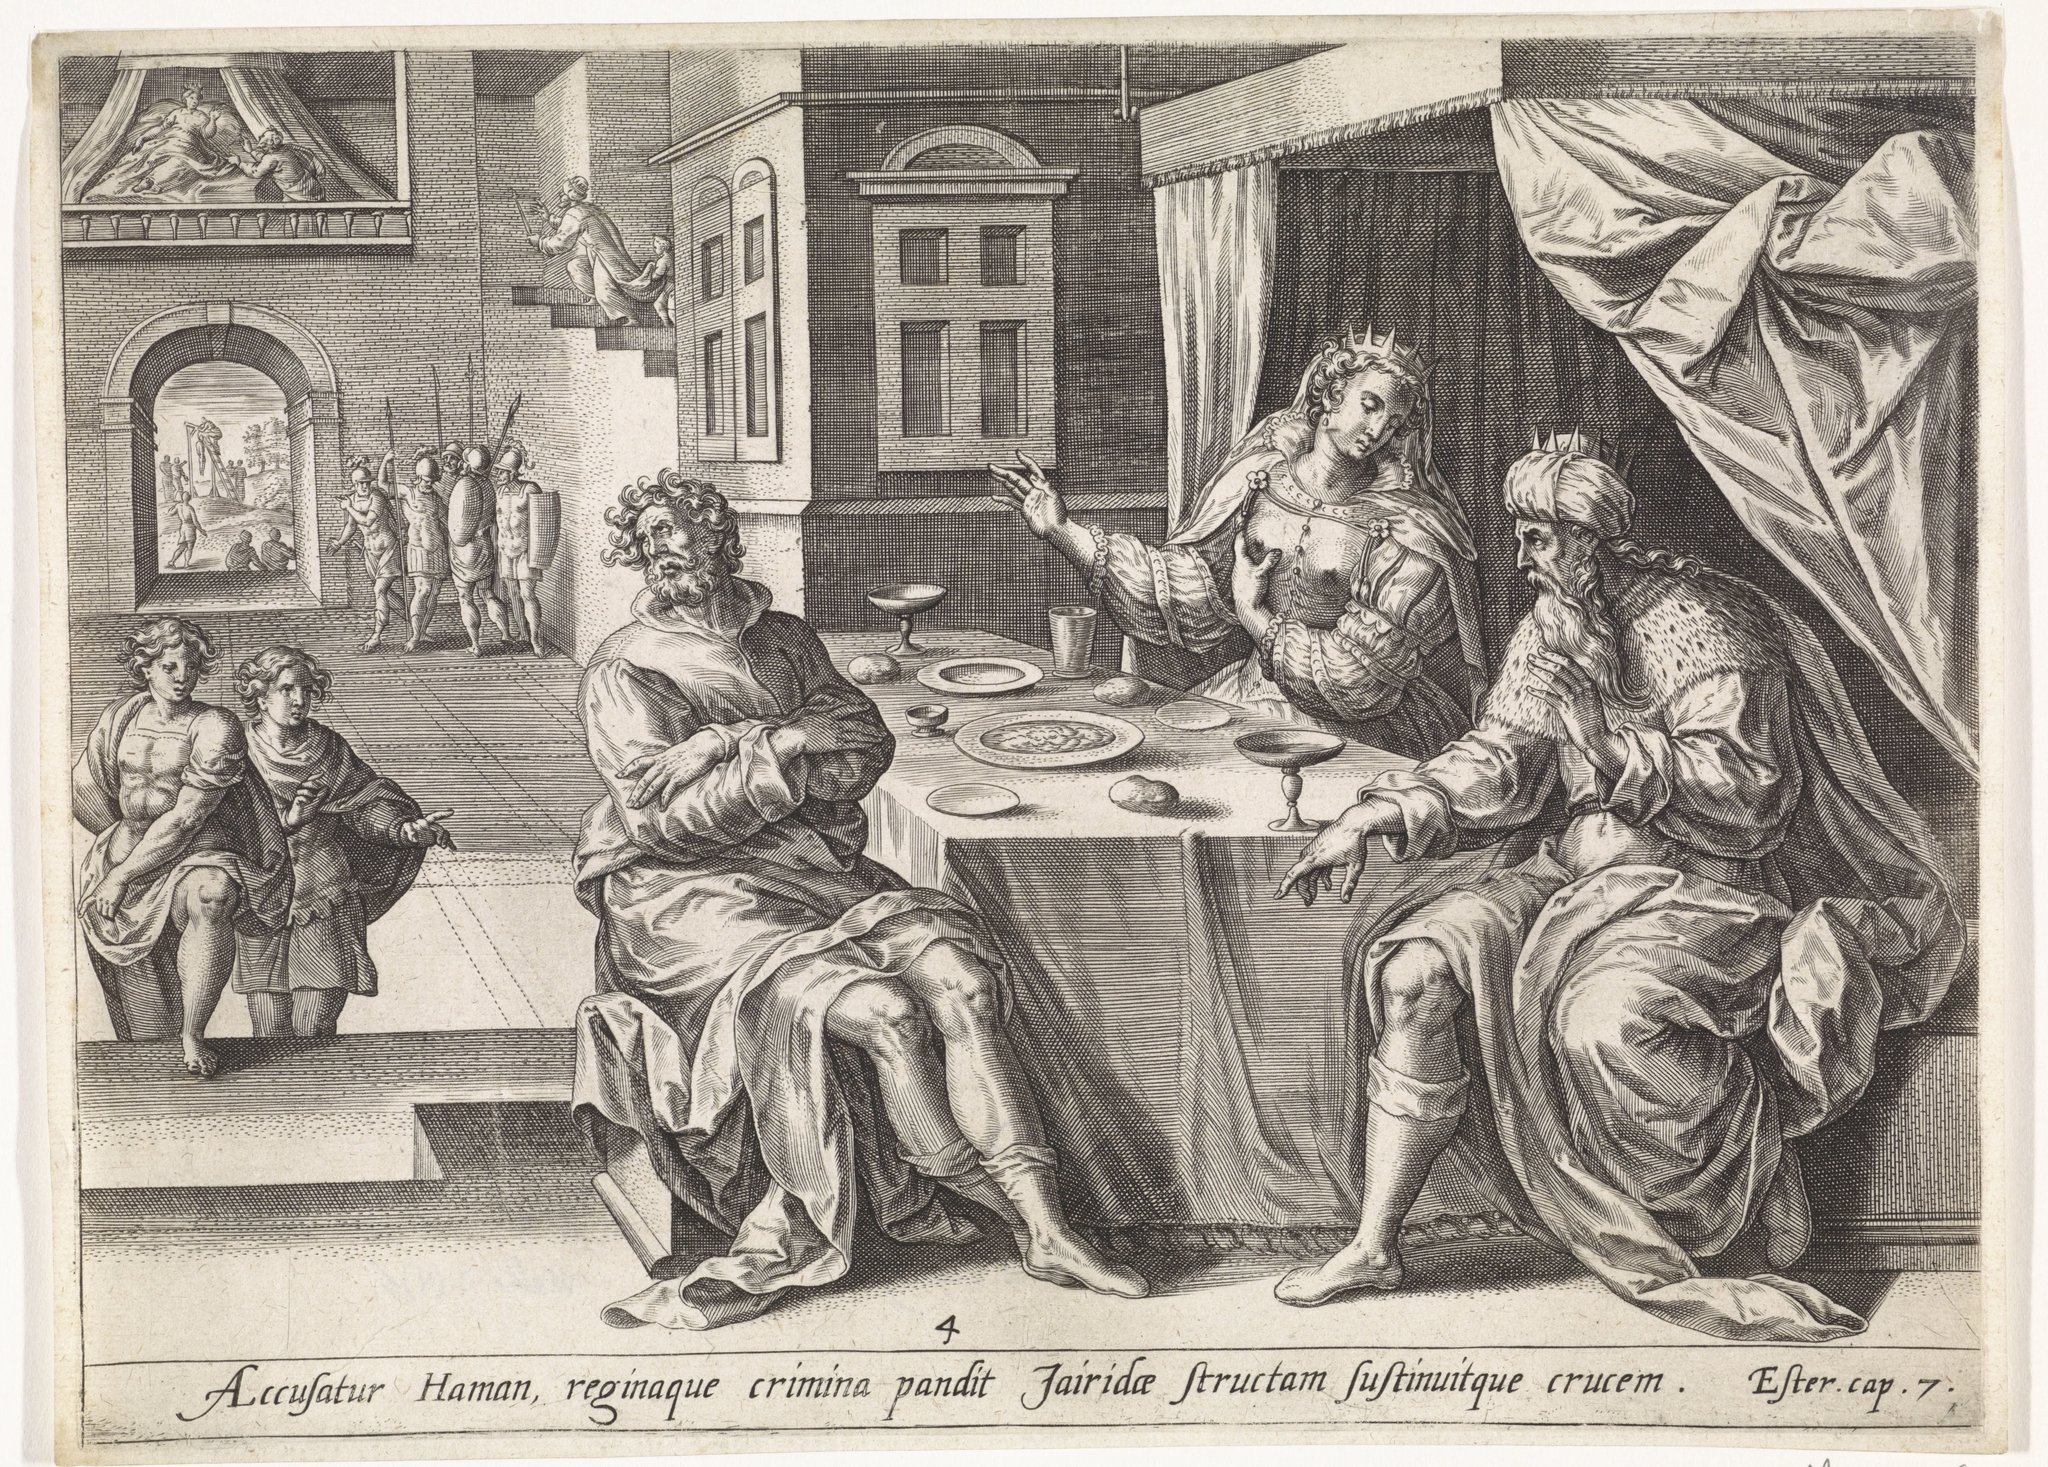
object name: print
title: Ester beschuldigt Haman tijdens de maaltijd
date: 1579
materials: paper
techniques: engraving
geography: antwerp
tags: as haman is kneeling at esther's feet or is prostrated on her couch king ahasuerus returns; haman is condemned to be hanged, esther accuses haman, haman on the gallows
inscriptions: collector's mark: Lugt 2760, collector's mark: Lugt 2228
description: Koning Ahasveros en zijn ambtenaar Haman zitten bij Ester aan tafel. Ester beschuldigt Haman van de geplande moord op het Joodse volk. Op de achtergrond is te zien hoe Haman vervolgens knielt bij het bed van koningin Ester en haar smeekt om zijn leven. Koning Ahasveros loopt op de trap en zal Haman beschuldigen van aanranding. Links is door een deur te zien hoe Haman wordt opgehangen. Onder de voorstelling een verwijzing in het Latijn naar de Bijbeltekst in Est. 7.